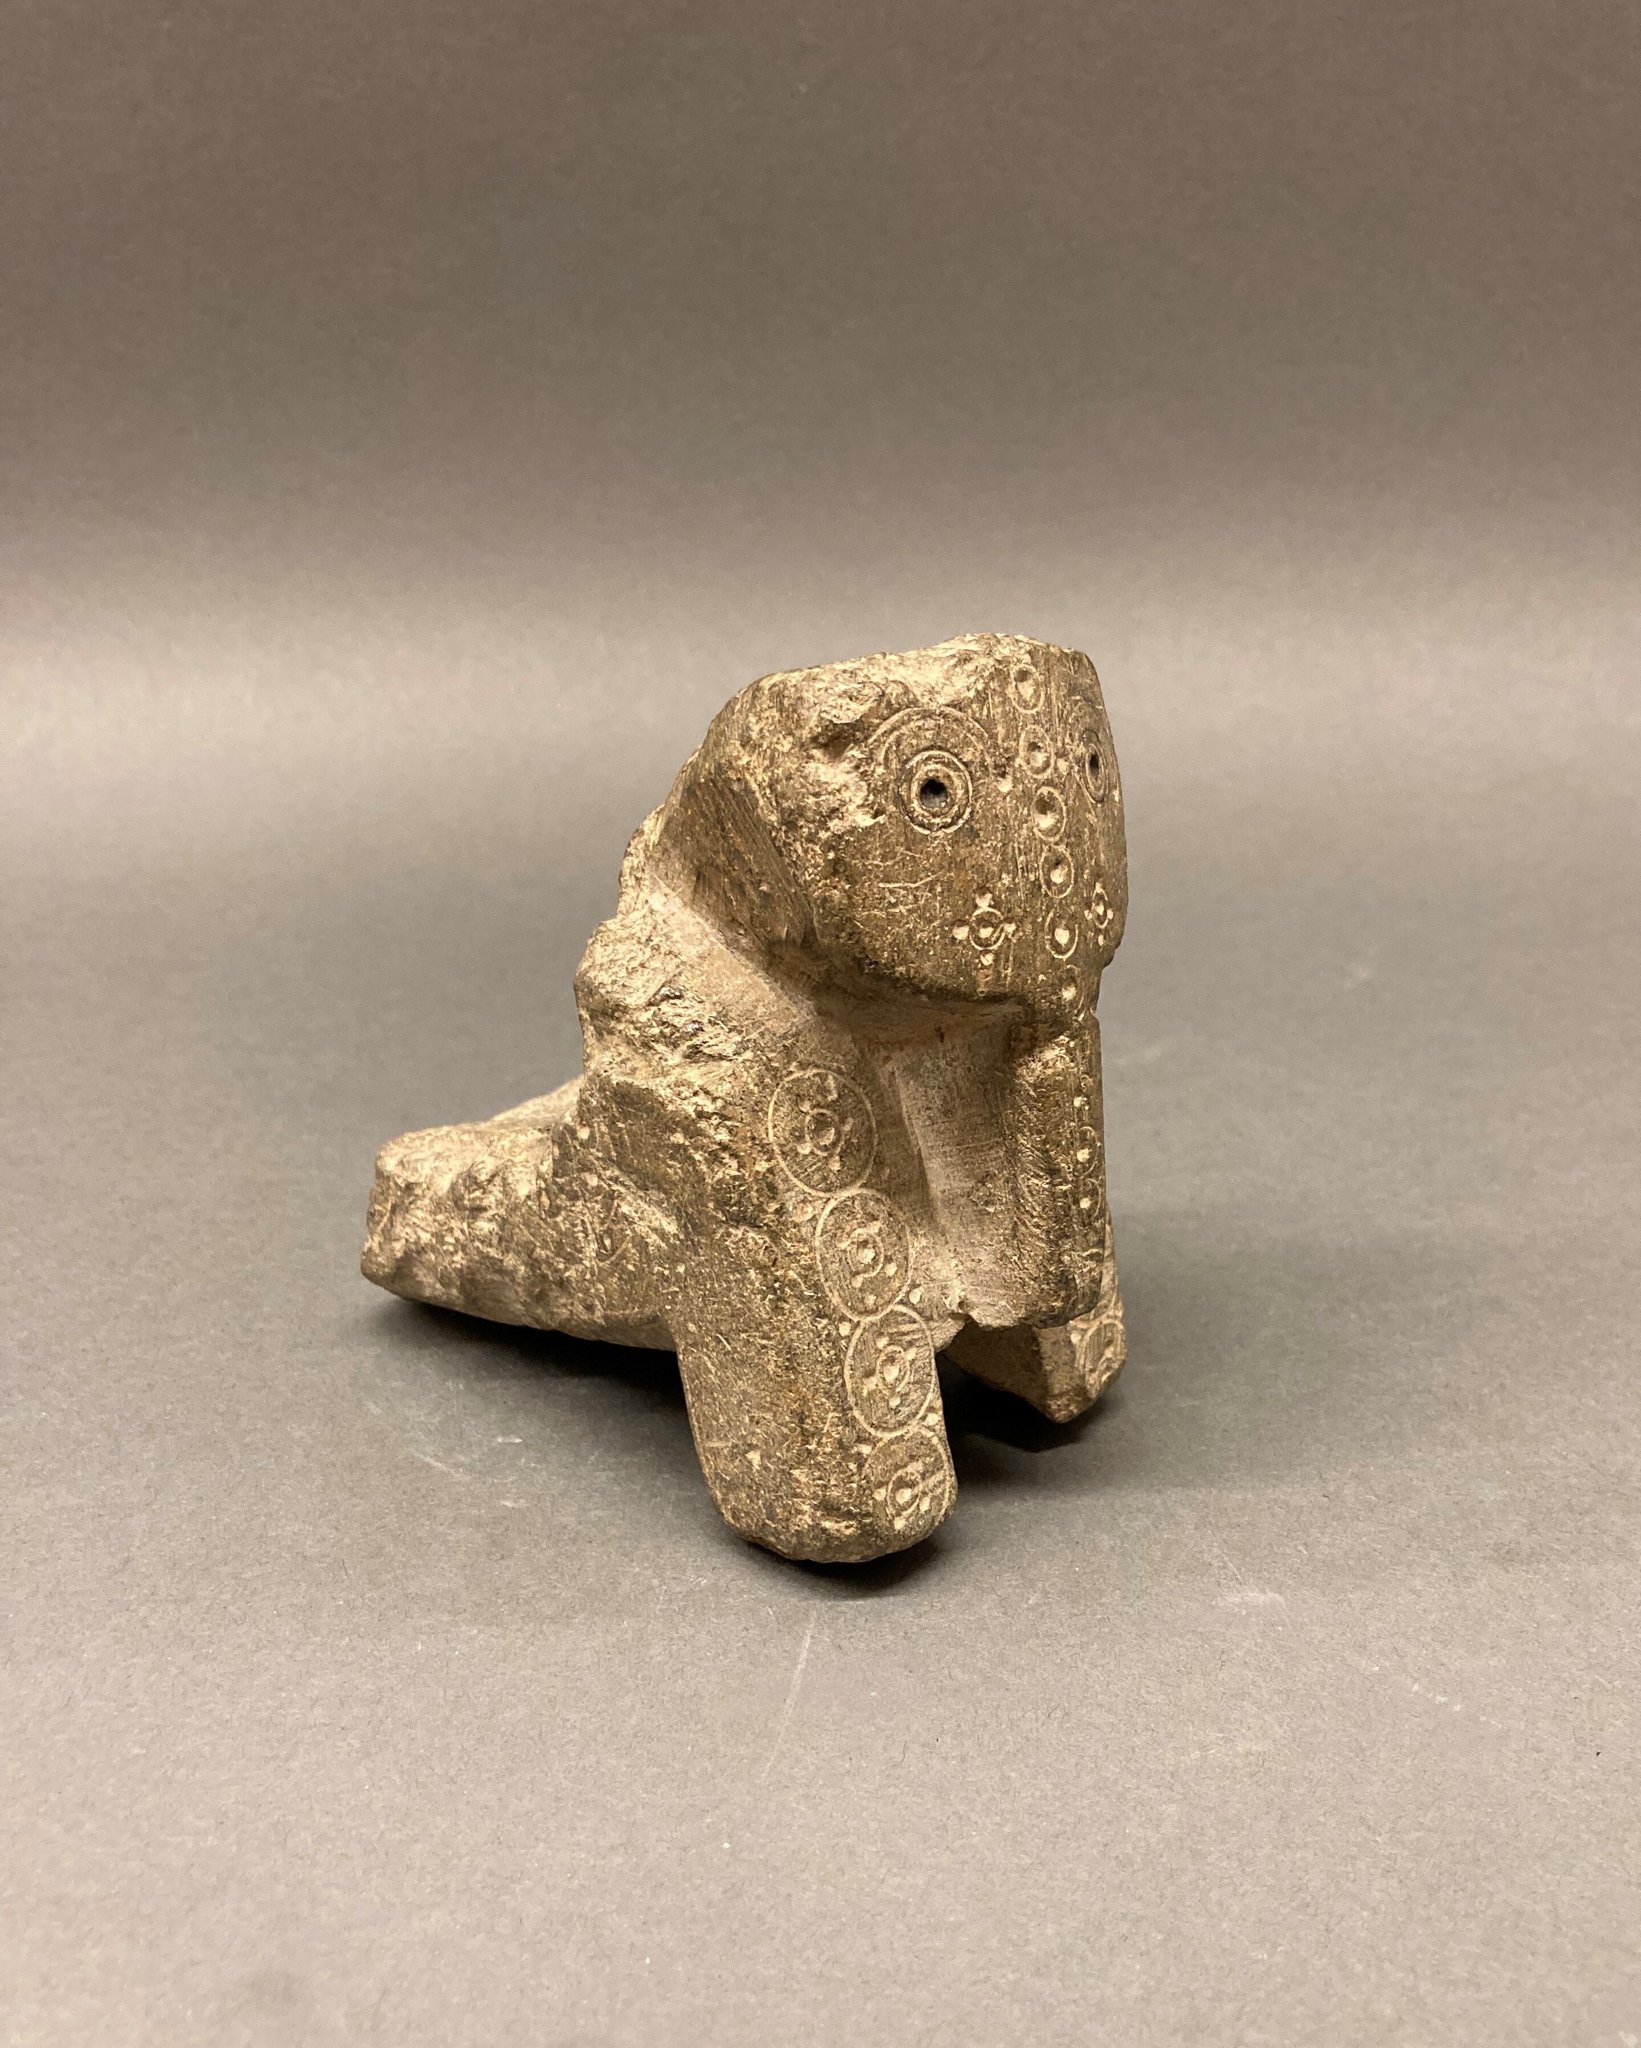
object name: lamp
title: Possibly a Lamp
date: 701-1300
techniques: carving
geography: iran